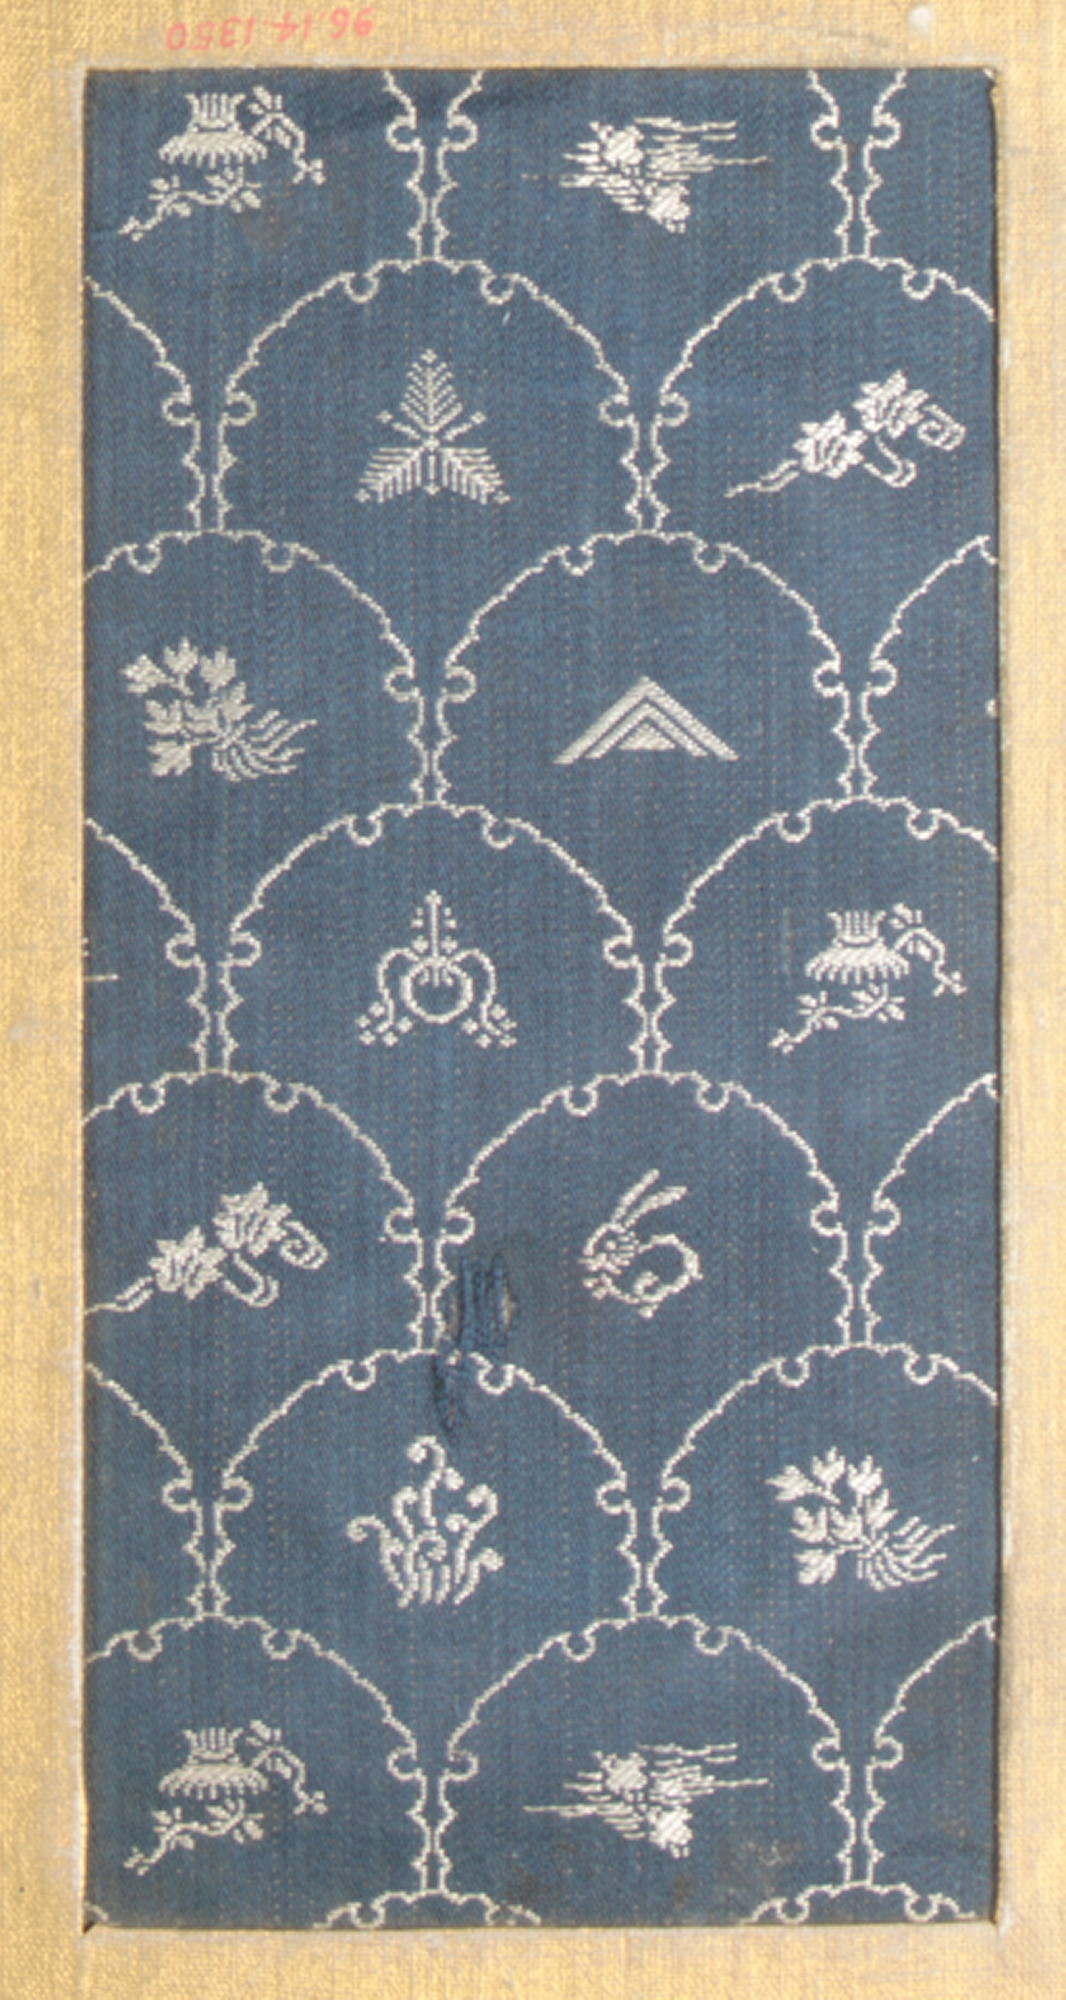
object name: piece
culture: japanese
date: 1701-1900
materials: silk